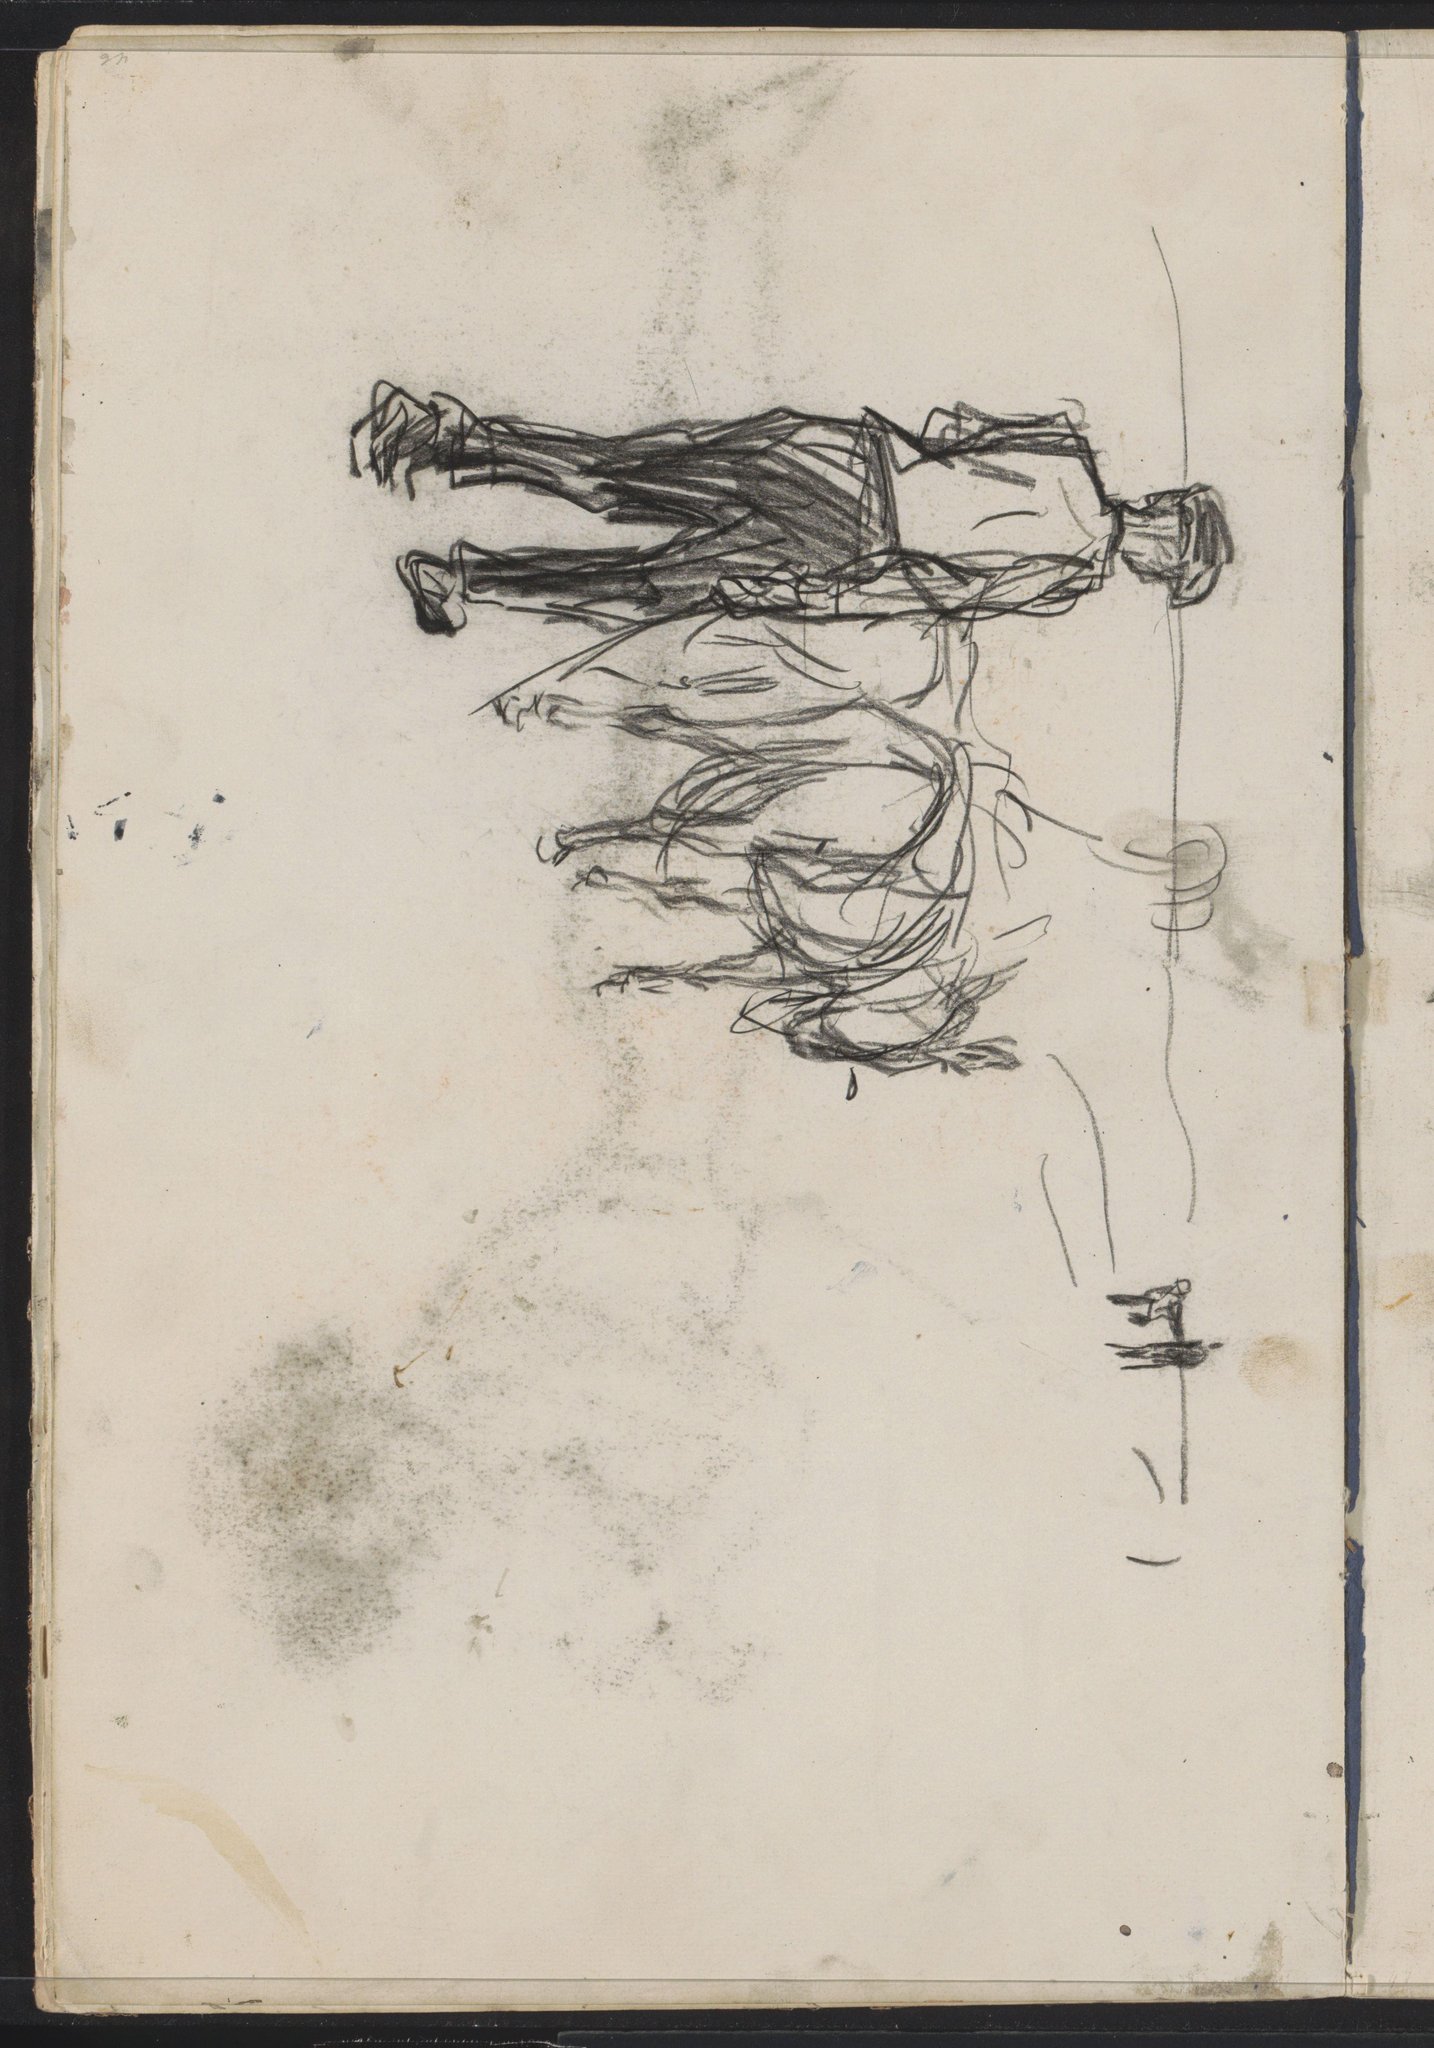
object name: sketchbook leaf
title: Ezelrijdende vrouw op het strand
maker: isaac israels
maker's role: draughtsman, painter, print maker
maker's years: 1865-1934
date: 1875-1934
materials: chalk, paper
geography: the hague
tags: adolescent, young woman, maiden, youth, adolescent, donkey-riding (on the beach)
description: Achter de ezels loopt de ezeljongen. Blad 5 verso uit schetsboek LXIX met 25 bladen.